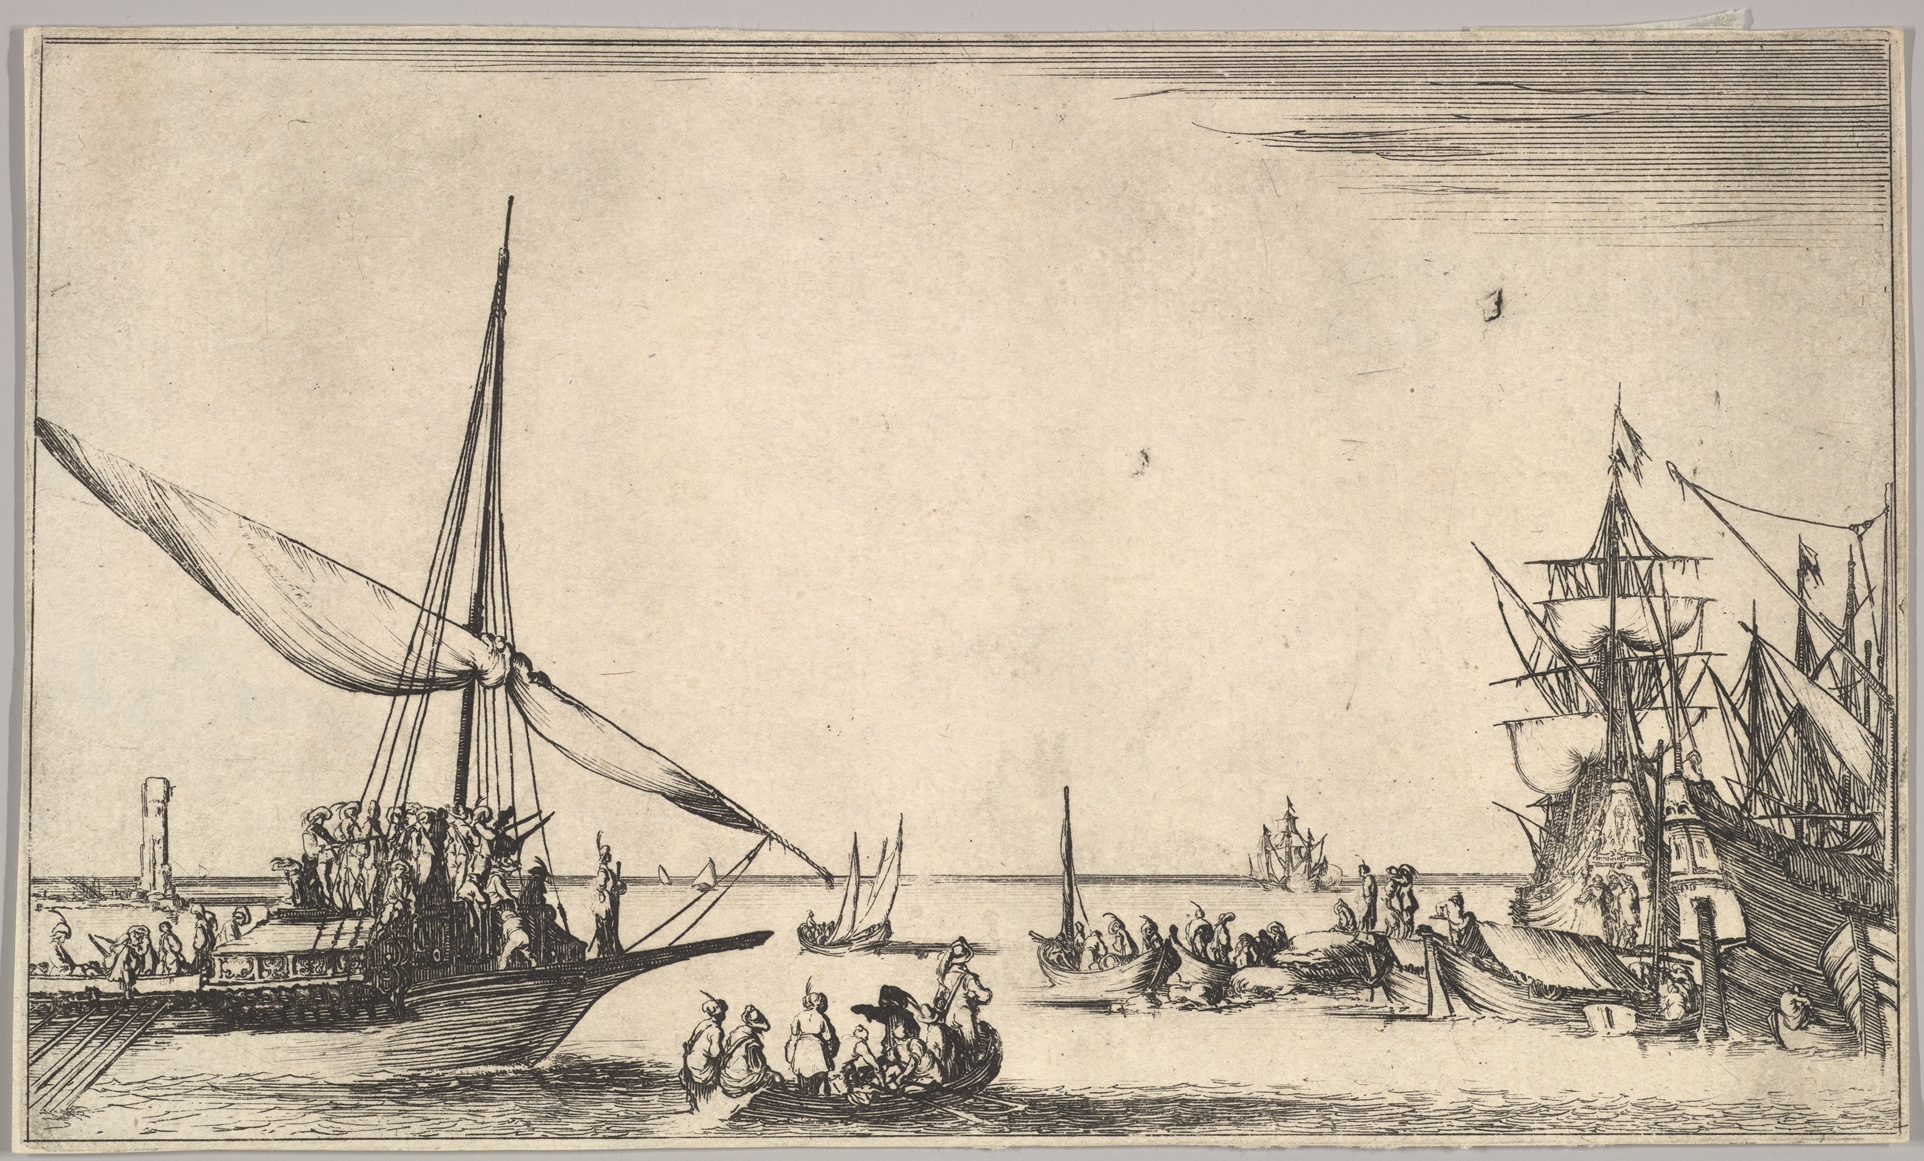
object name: print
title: A galley arriving at port to left, several rowboats in center, ships at port to right, from "Set of eight nautical landscapes" (Suite de huit Marines)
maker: stefano della bella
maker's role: artist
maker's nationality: italian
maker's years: 1610-1664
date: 1639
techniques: etching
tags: boats,ships